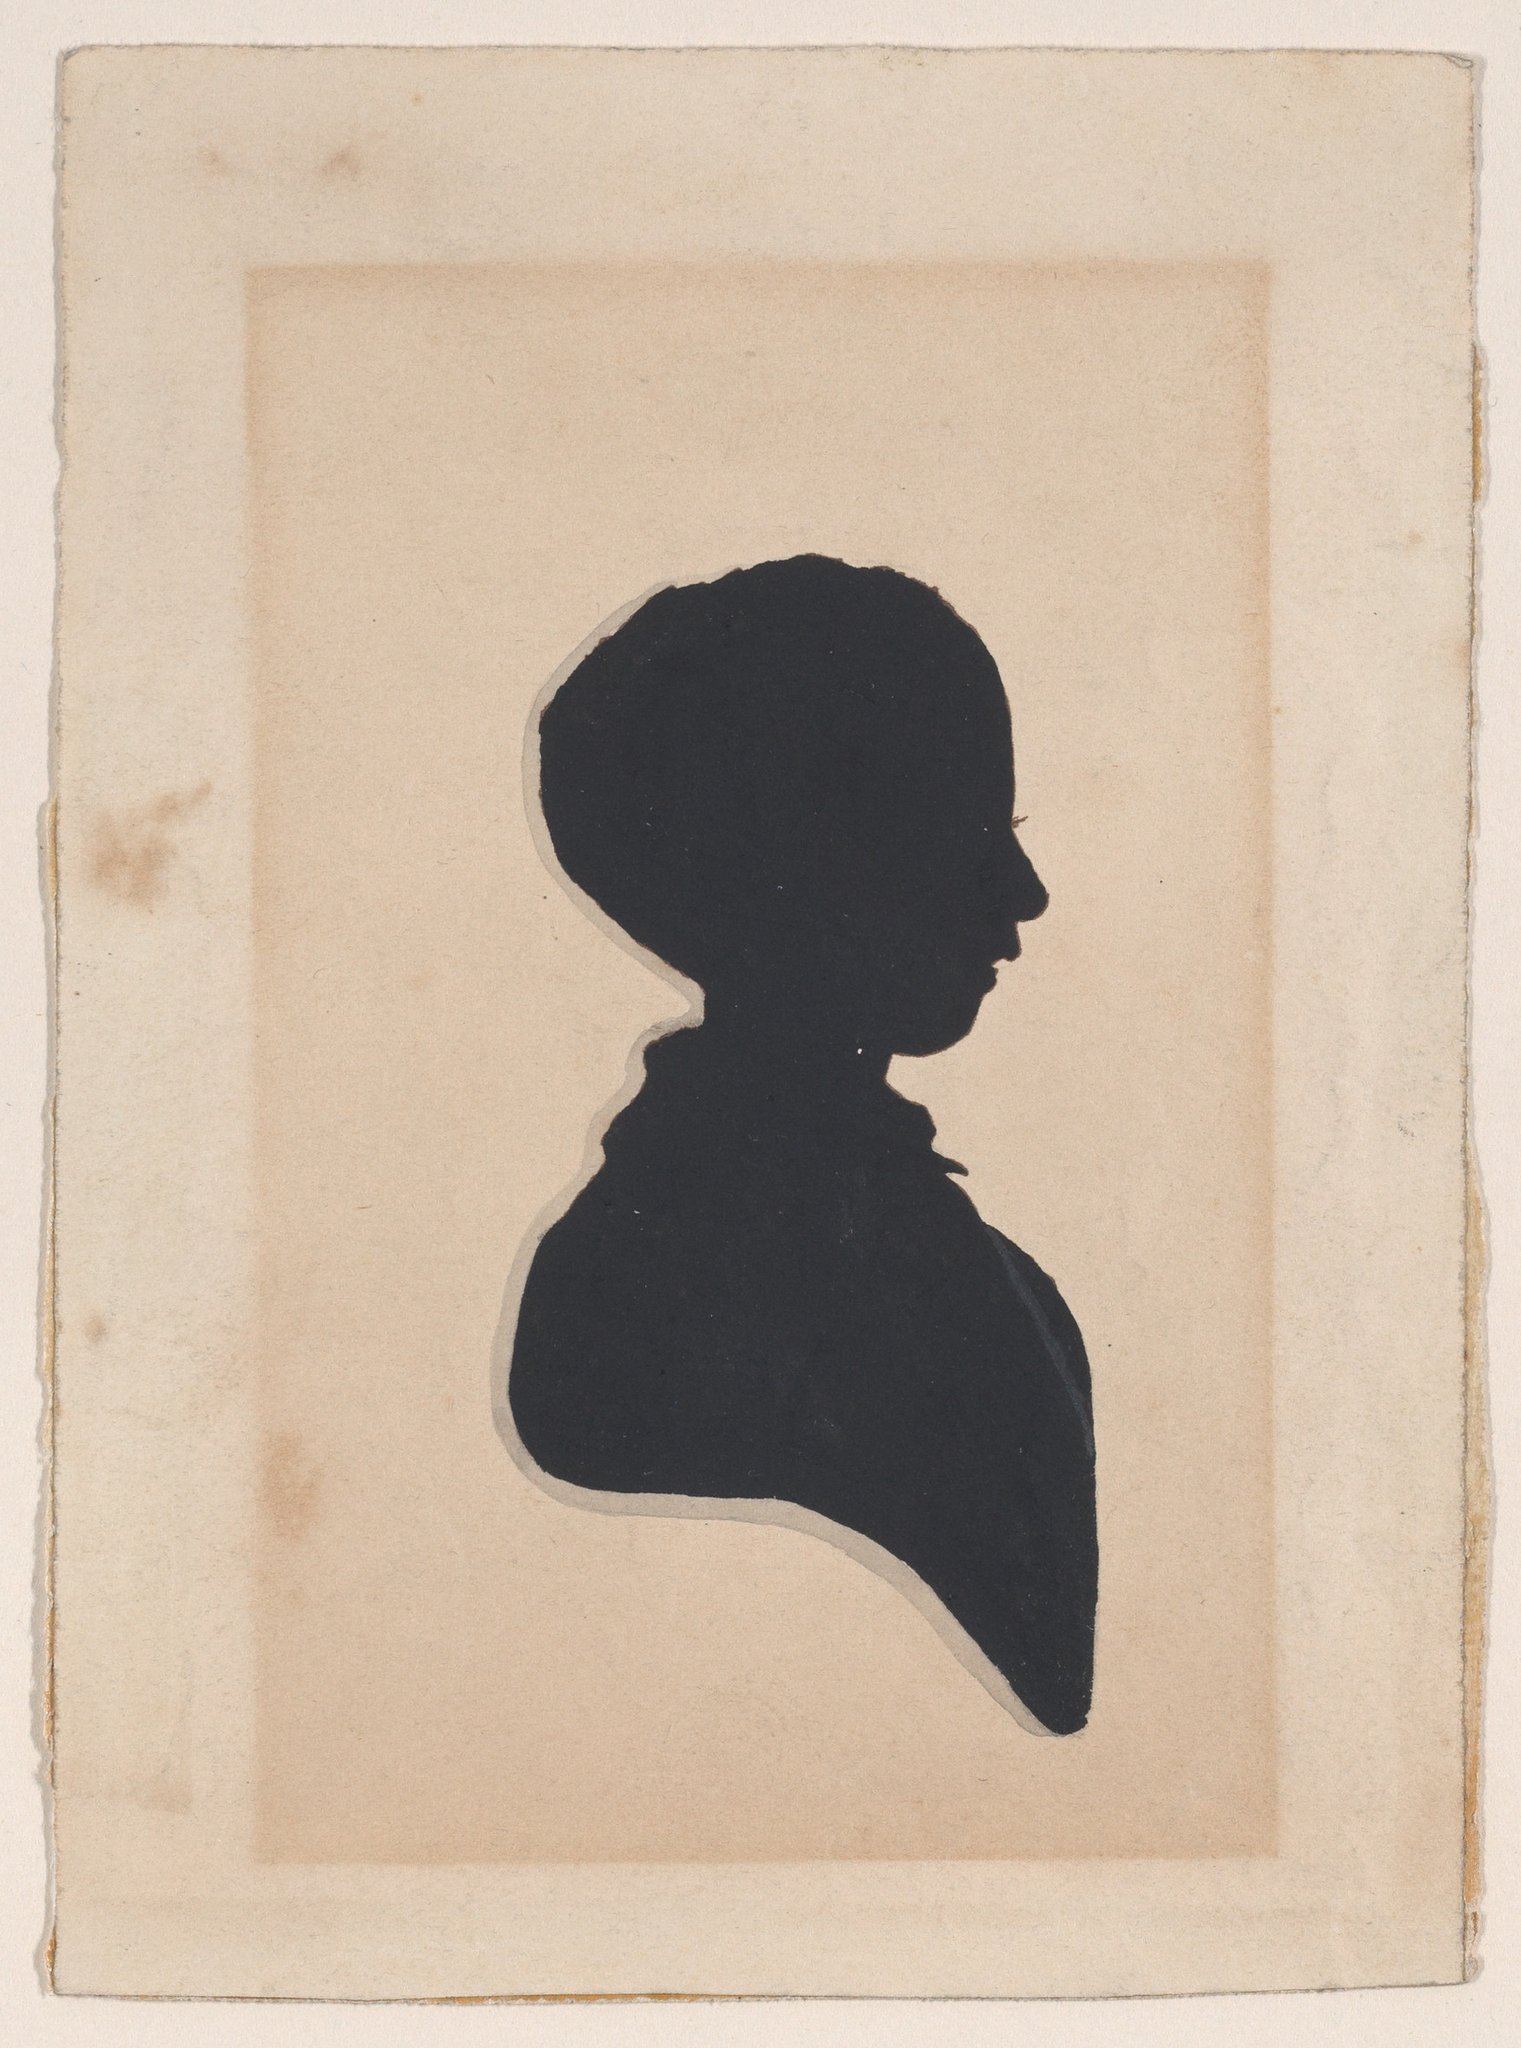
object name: drawing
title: Silhouette of Cecil Brent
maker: a. brent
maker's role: artist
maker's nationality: british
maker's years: 1800-1900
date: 1801-1900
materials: ink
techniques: brush, pen, wash